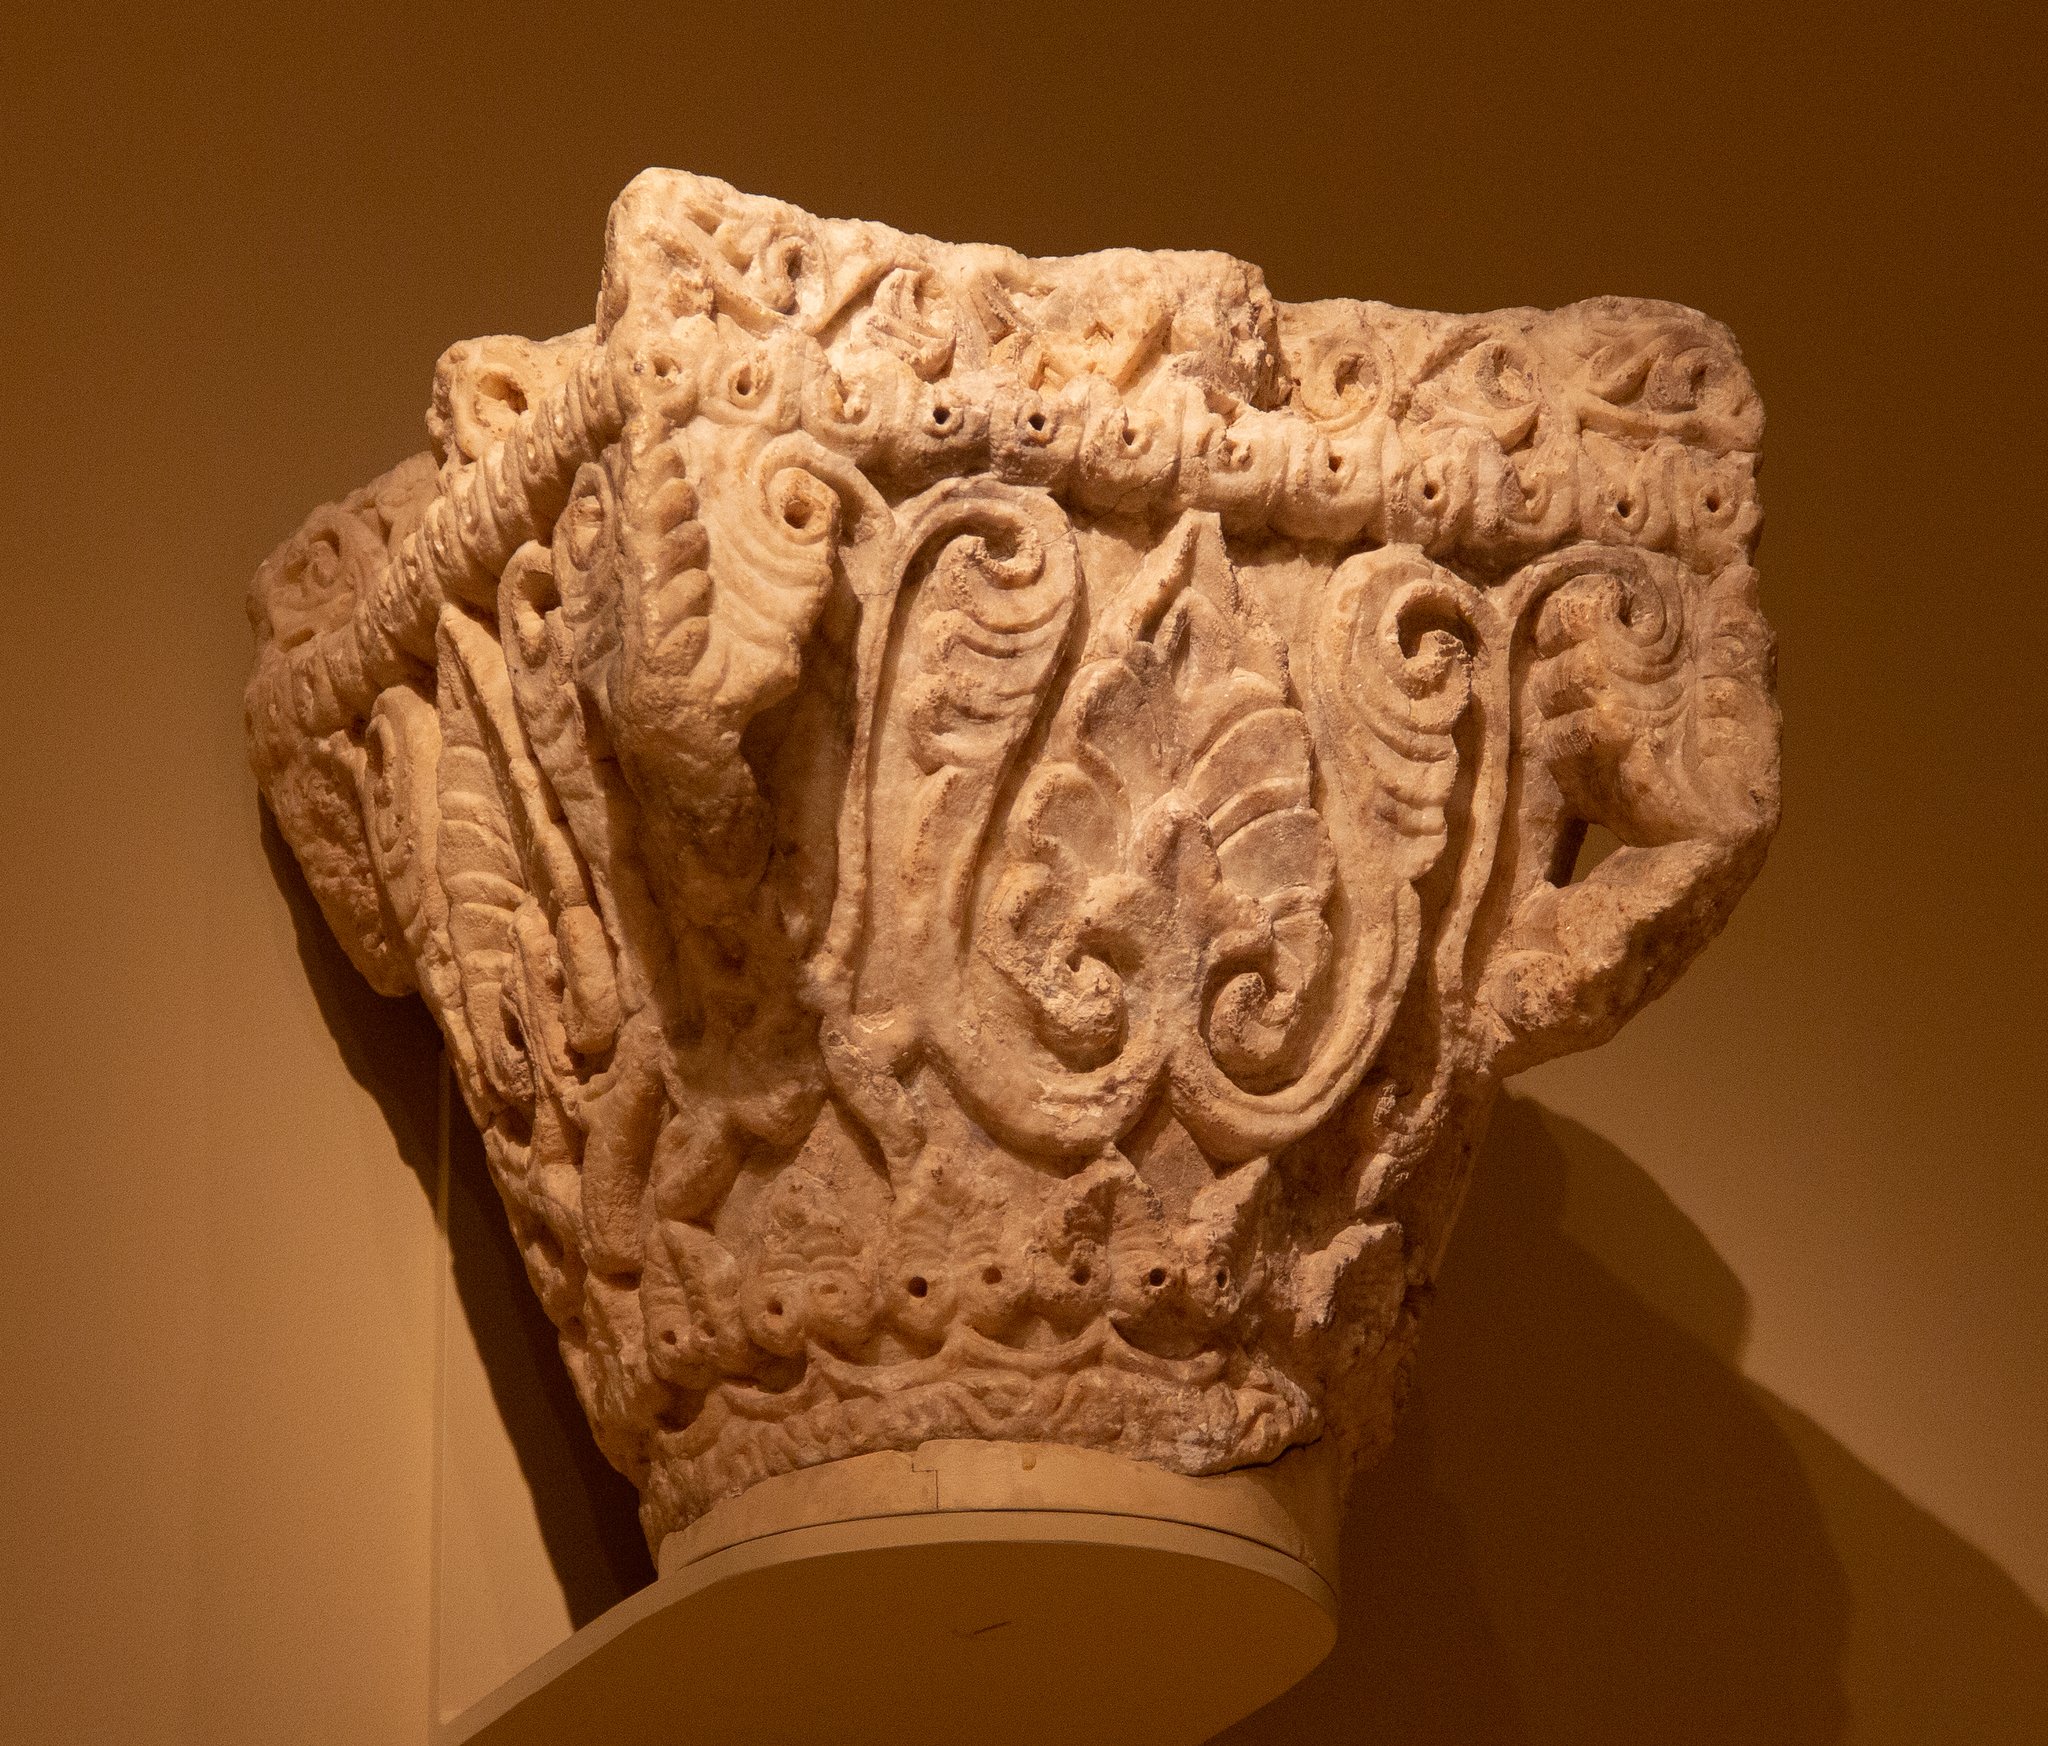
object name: capital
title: Capital with Palmettes and Leaves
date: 767-800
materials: alabaster, gypsum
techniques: carving, relief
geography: syria